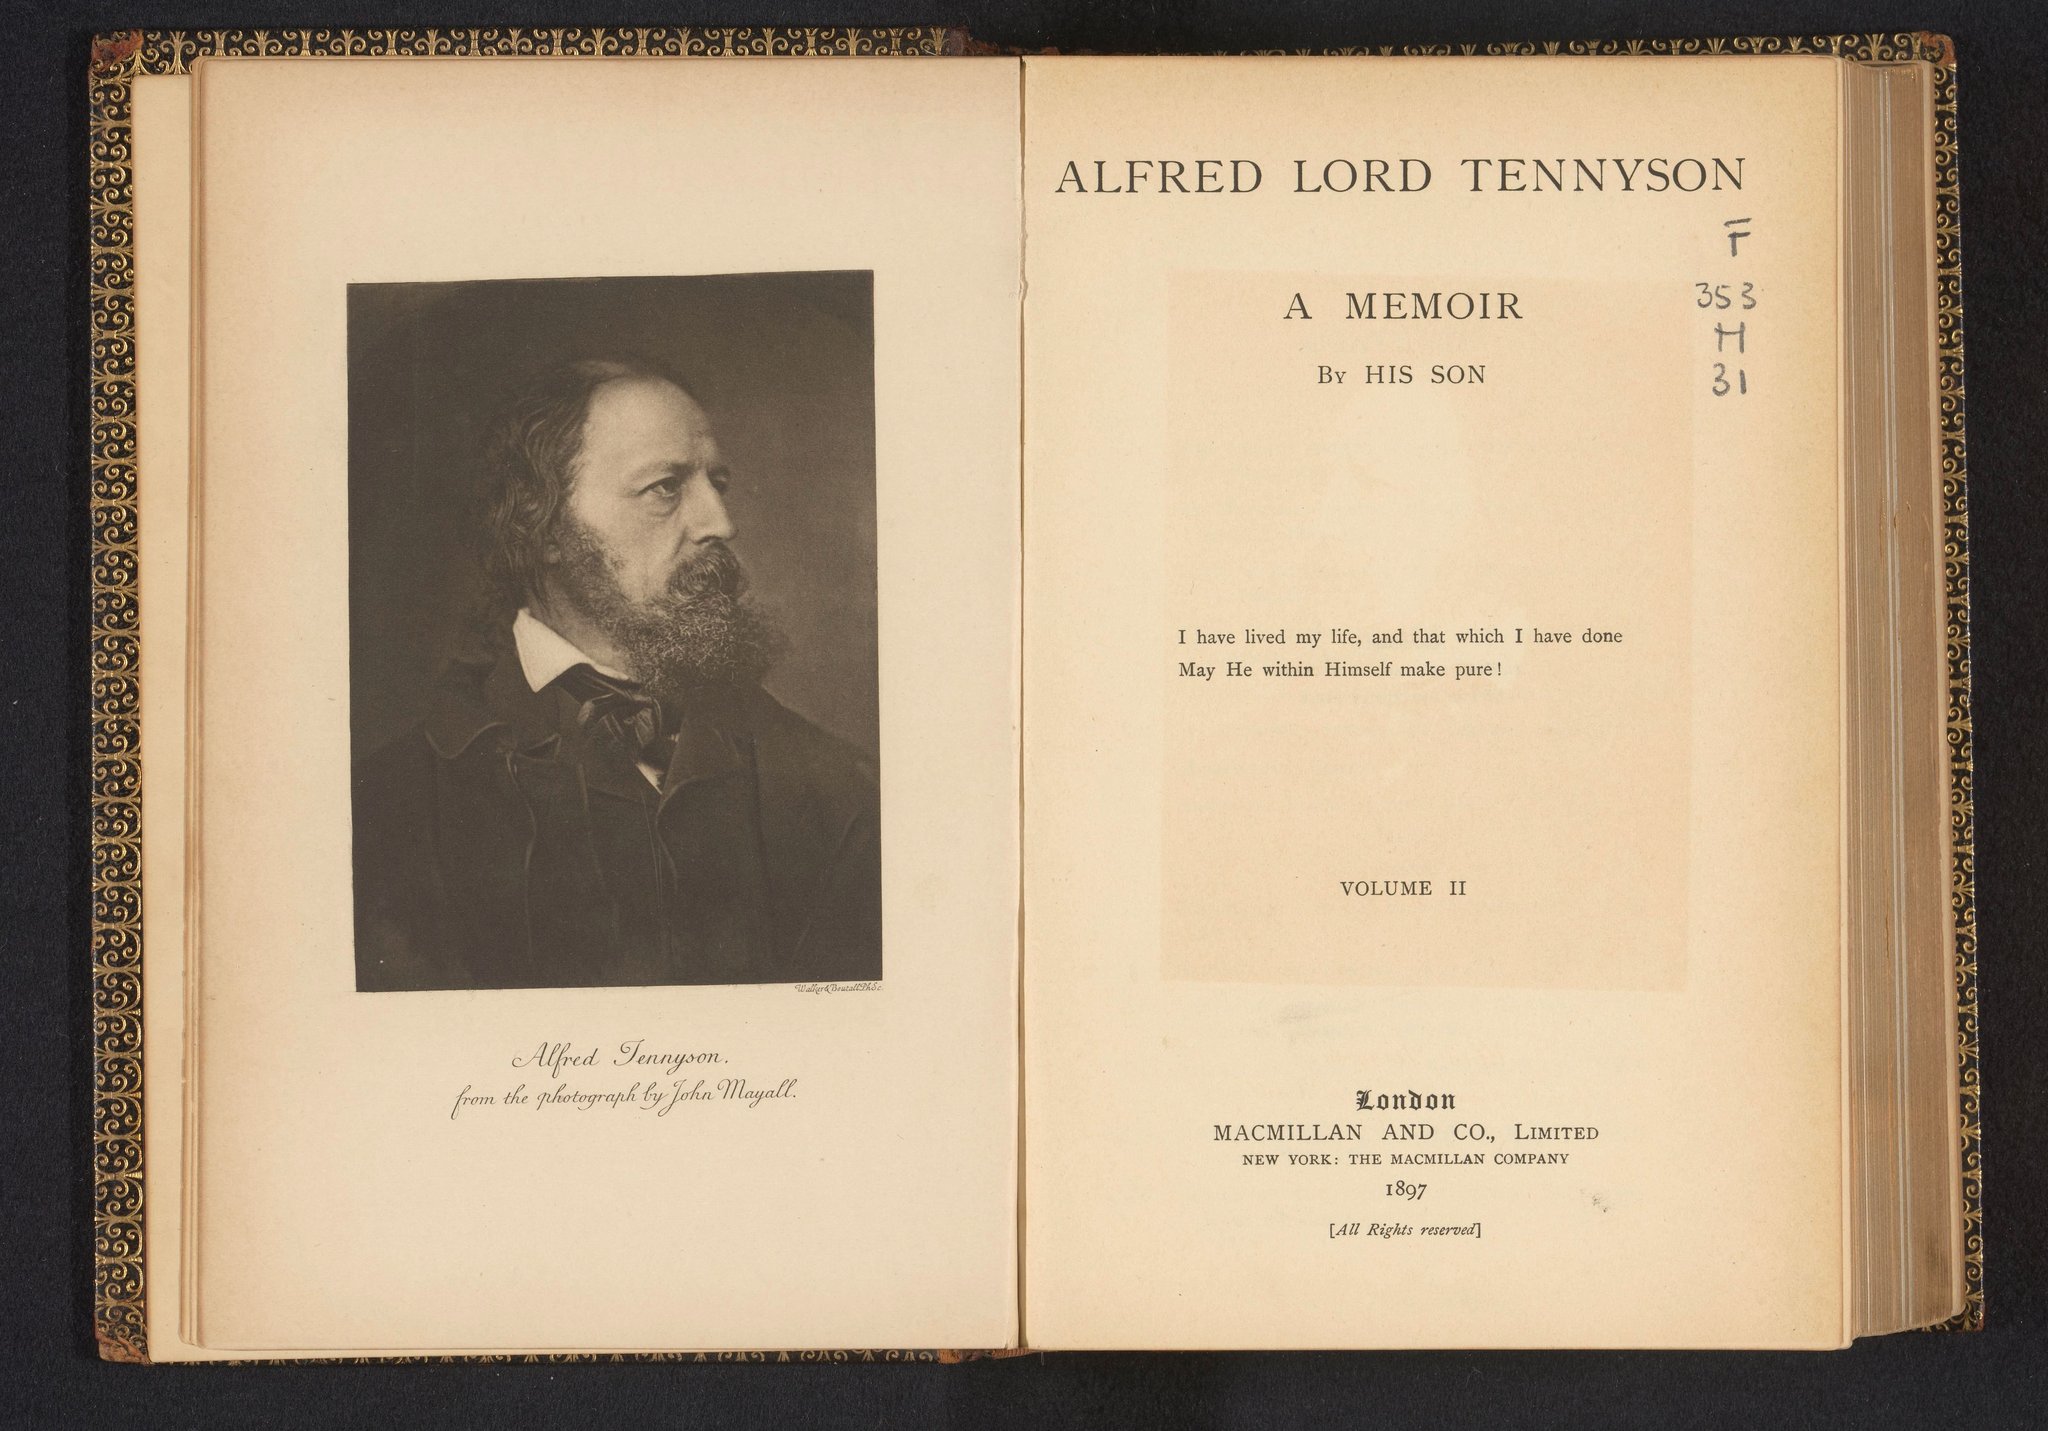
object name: book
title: Alfred Lord Tennyson a memoir vol. II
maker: hallam tennyson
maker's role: gouverneur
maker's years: 1852-1928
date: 1897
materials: cardboard, linen, paper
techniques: photoaquatint, printing, marbled paper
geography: london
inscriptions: inscription: ‘L. Jackson’